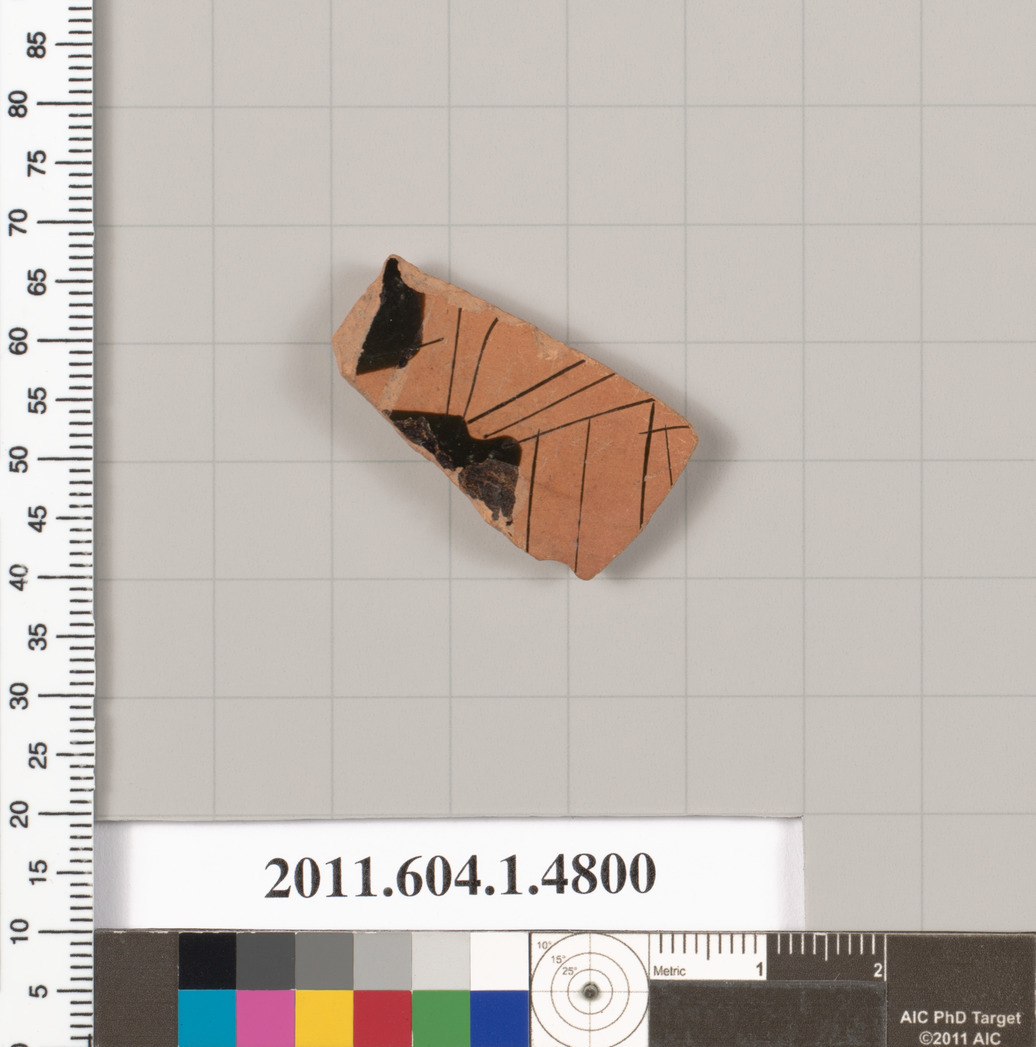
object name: kylix fragment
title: Terracotta fragment of a kylix (drinking cup)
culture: greek, attic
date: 475-451 BCE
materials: terracotta